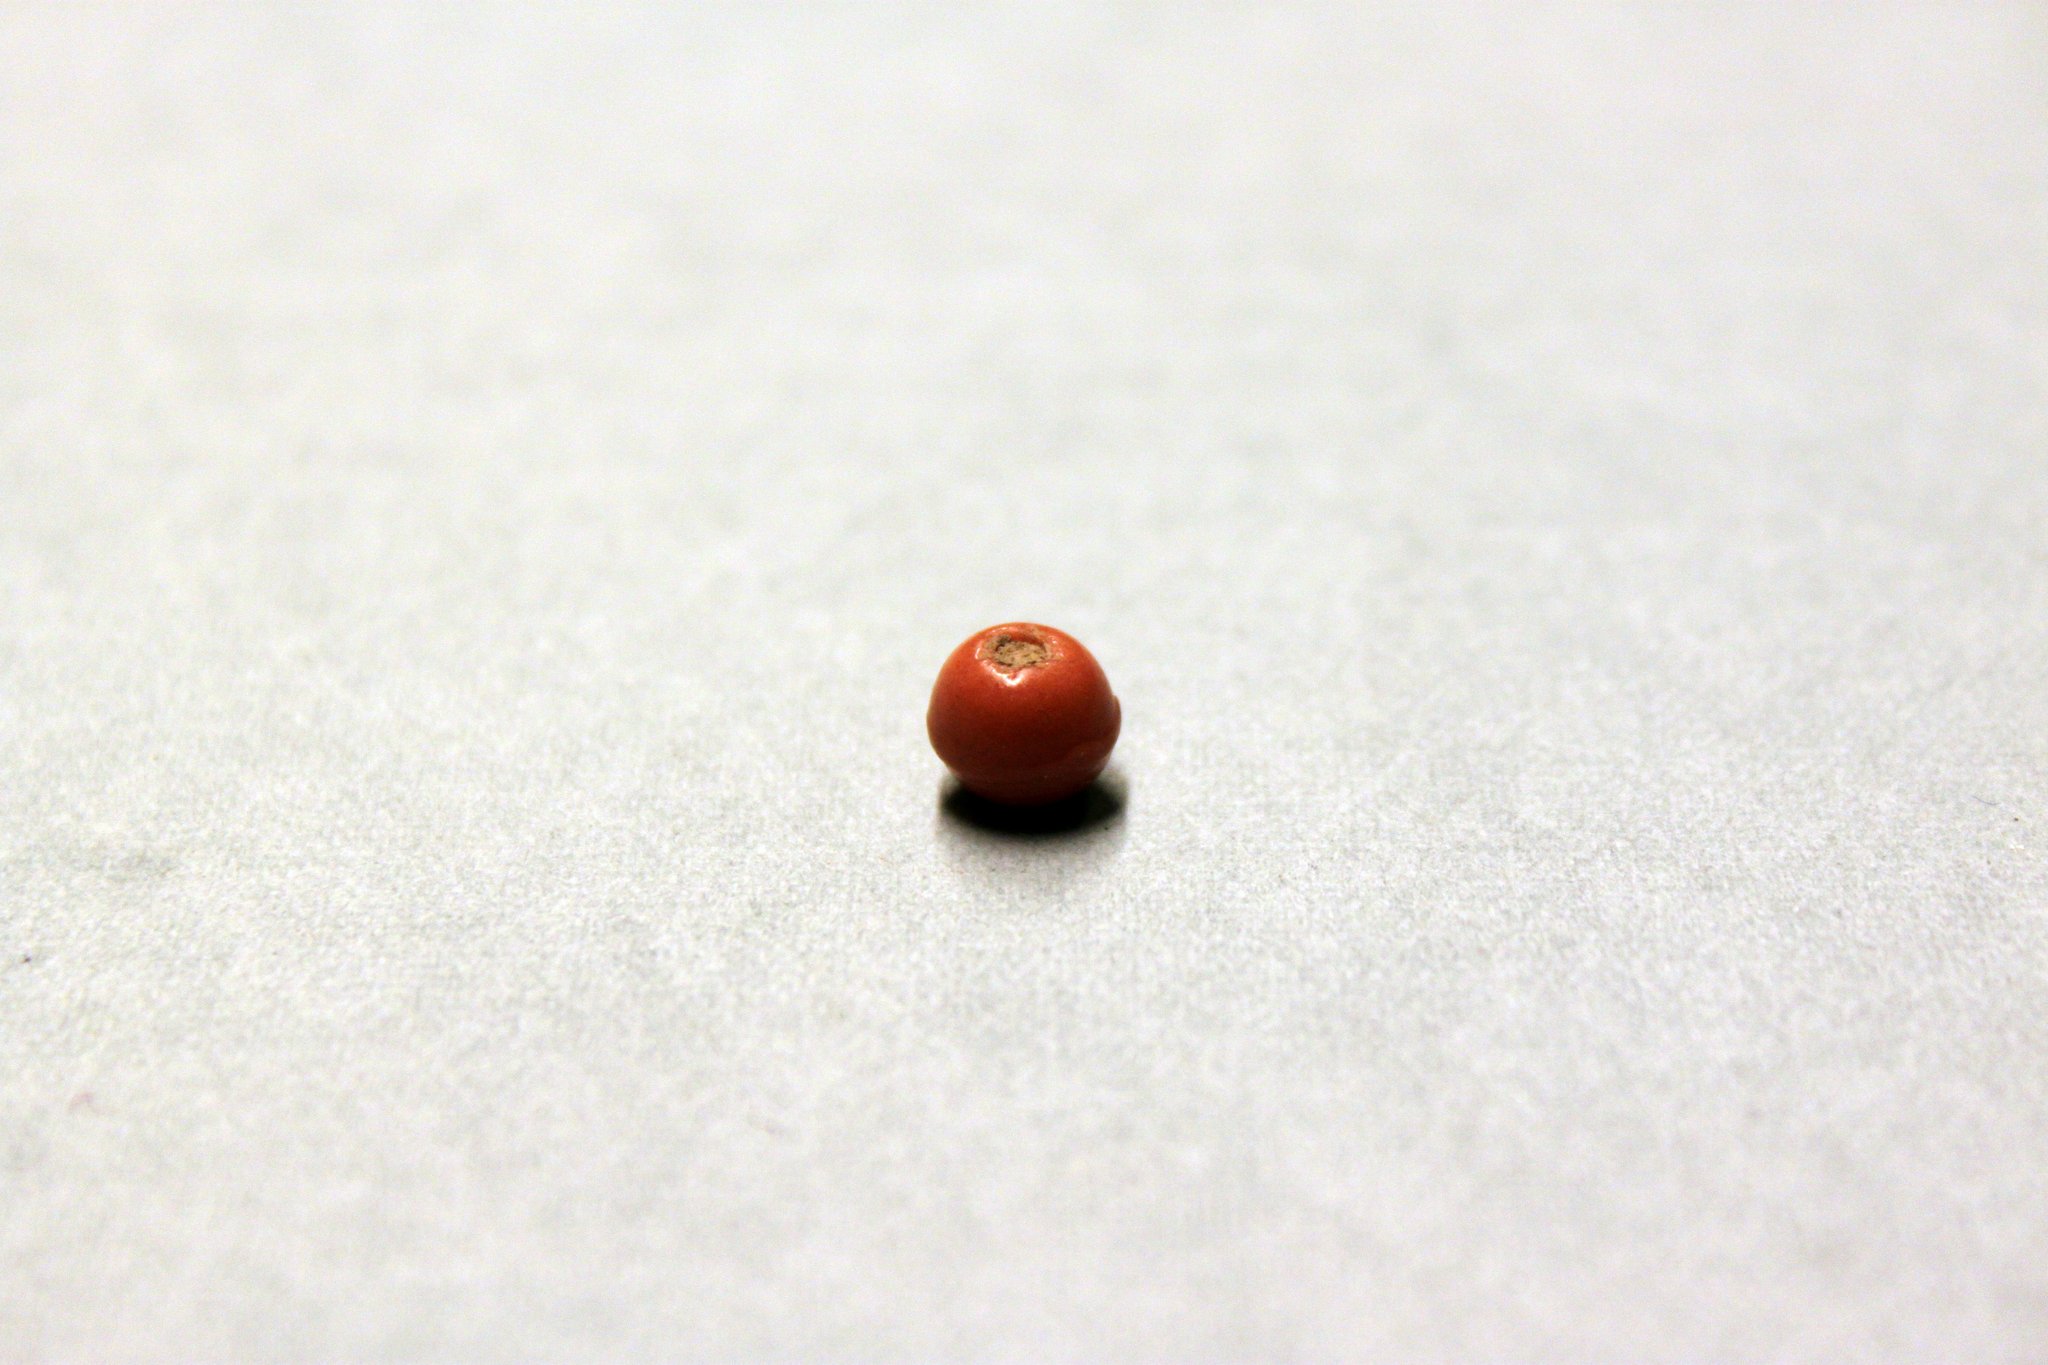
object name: bead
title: Beads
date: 701-1300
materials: glass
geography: iran